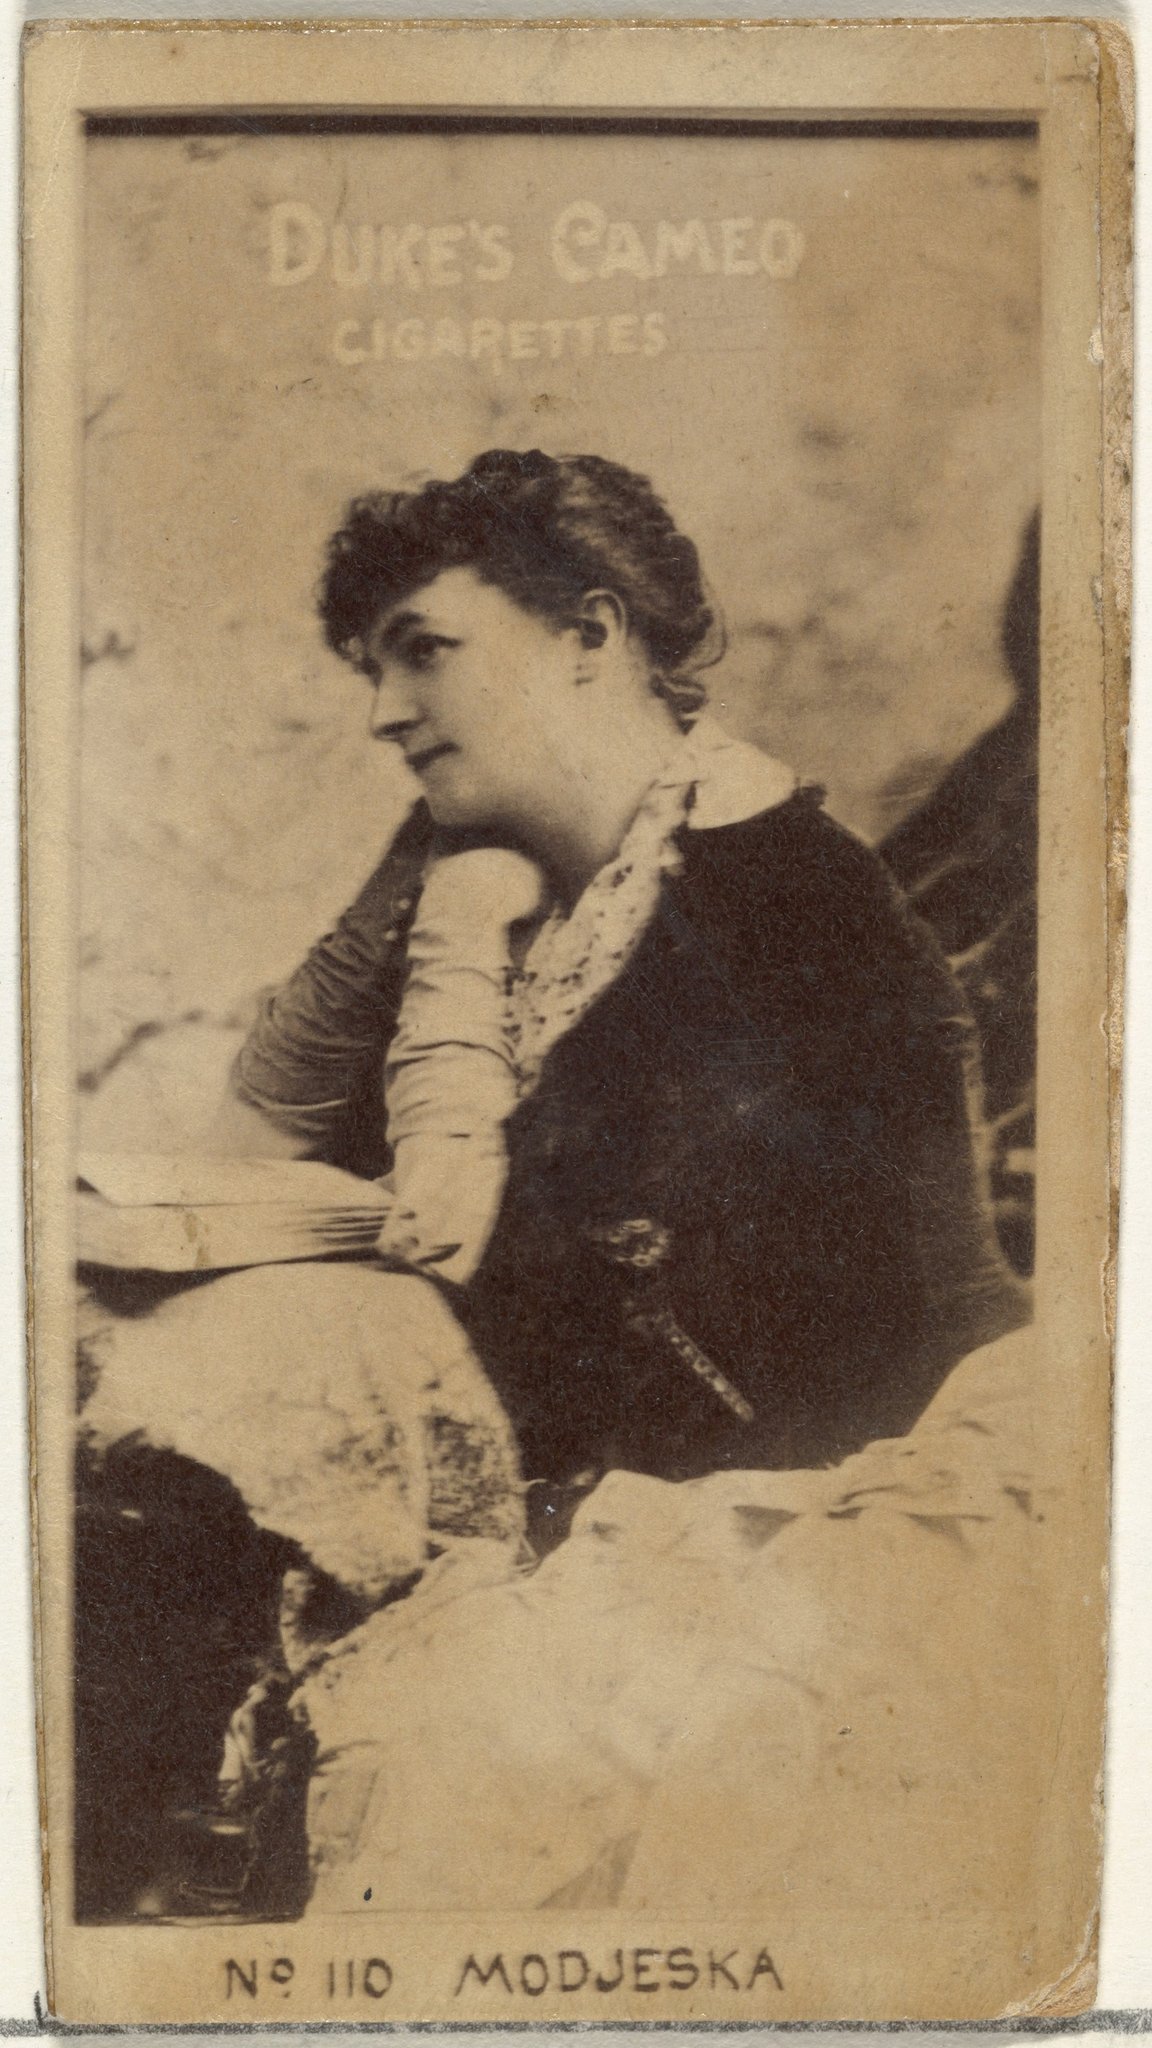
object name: photograph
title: Card Number 110, Modjeska, from the Actors and Actresses series (N145-4) issued by Duke Sons & Co. to promote Cameo Cigarettes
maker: w. duke, sons & co.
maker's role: publisher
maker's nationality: american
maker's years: 1870-1920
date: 1880-1889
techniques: albumen silver print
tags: women,actresses